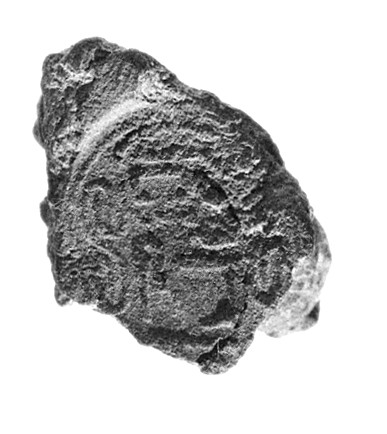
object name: sealing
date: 1981-1640 BCE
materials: mud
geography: egypt